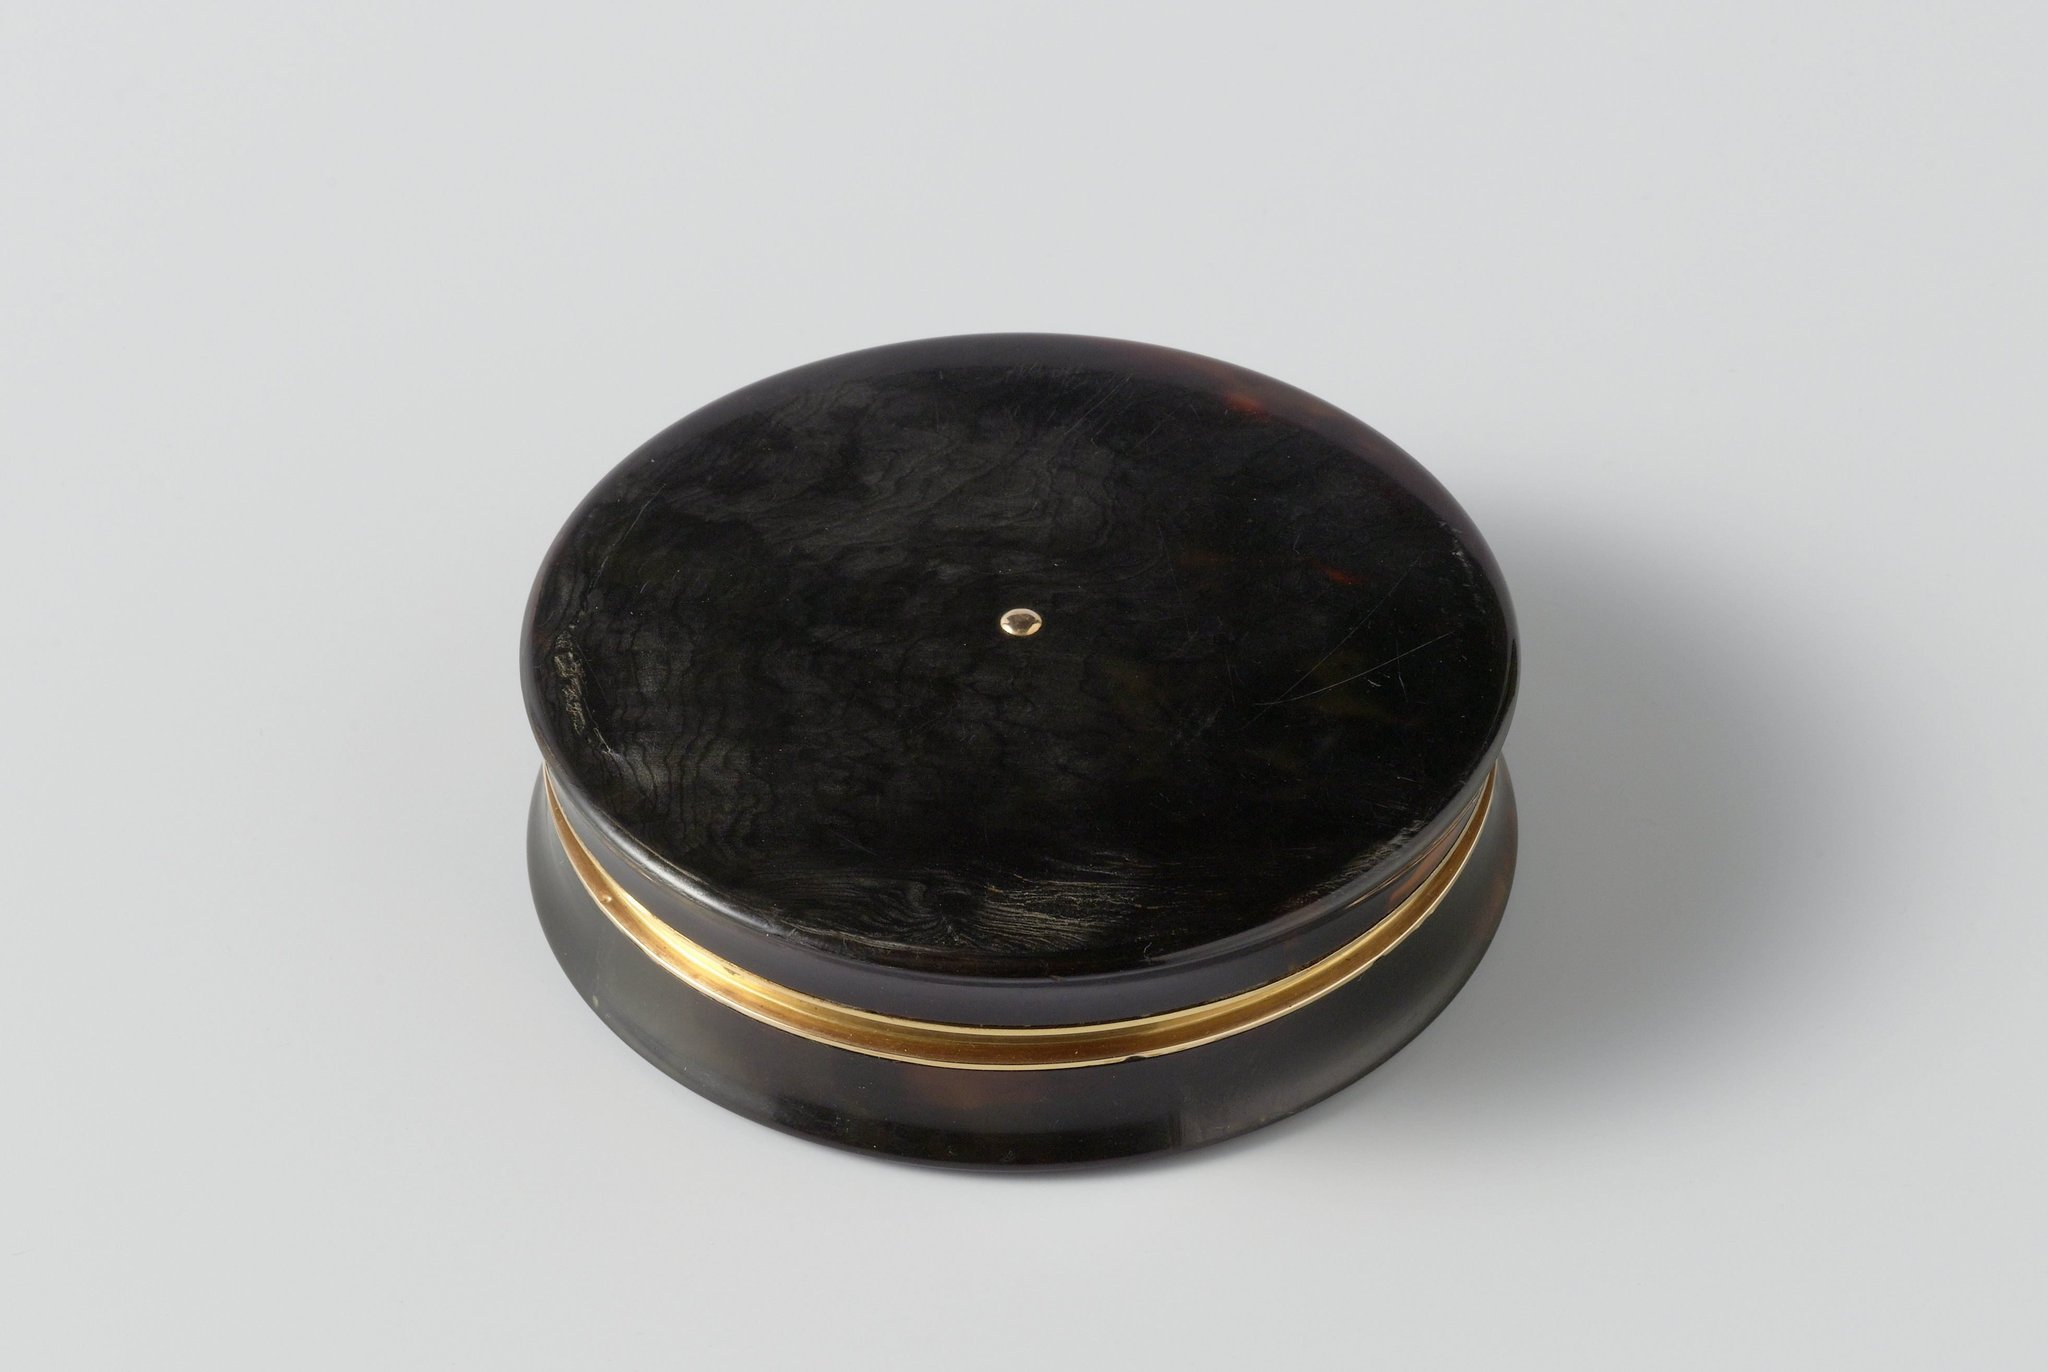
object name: medal box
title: Penningdoos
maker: Anonymous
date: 1688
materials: brass, shell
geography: amsterdam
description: Doosje van schildpad met messing (?) schroef. NB Dit betreft niet de doos die oorspronkelijk bij de penning NG-2008-41-B hoorde.